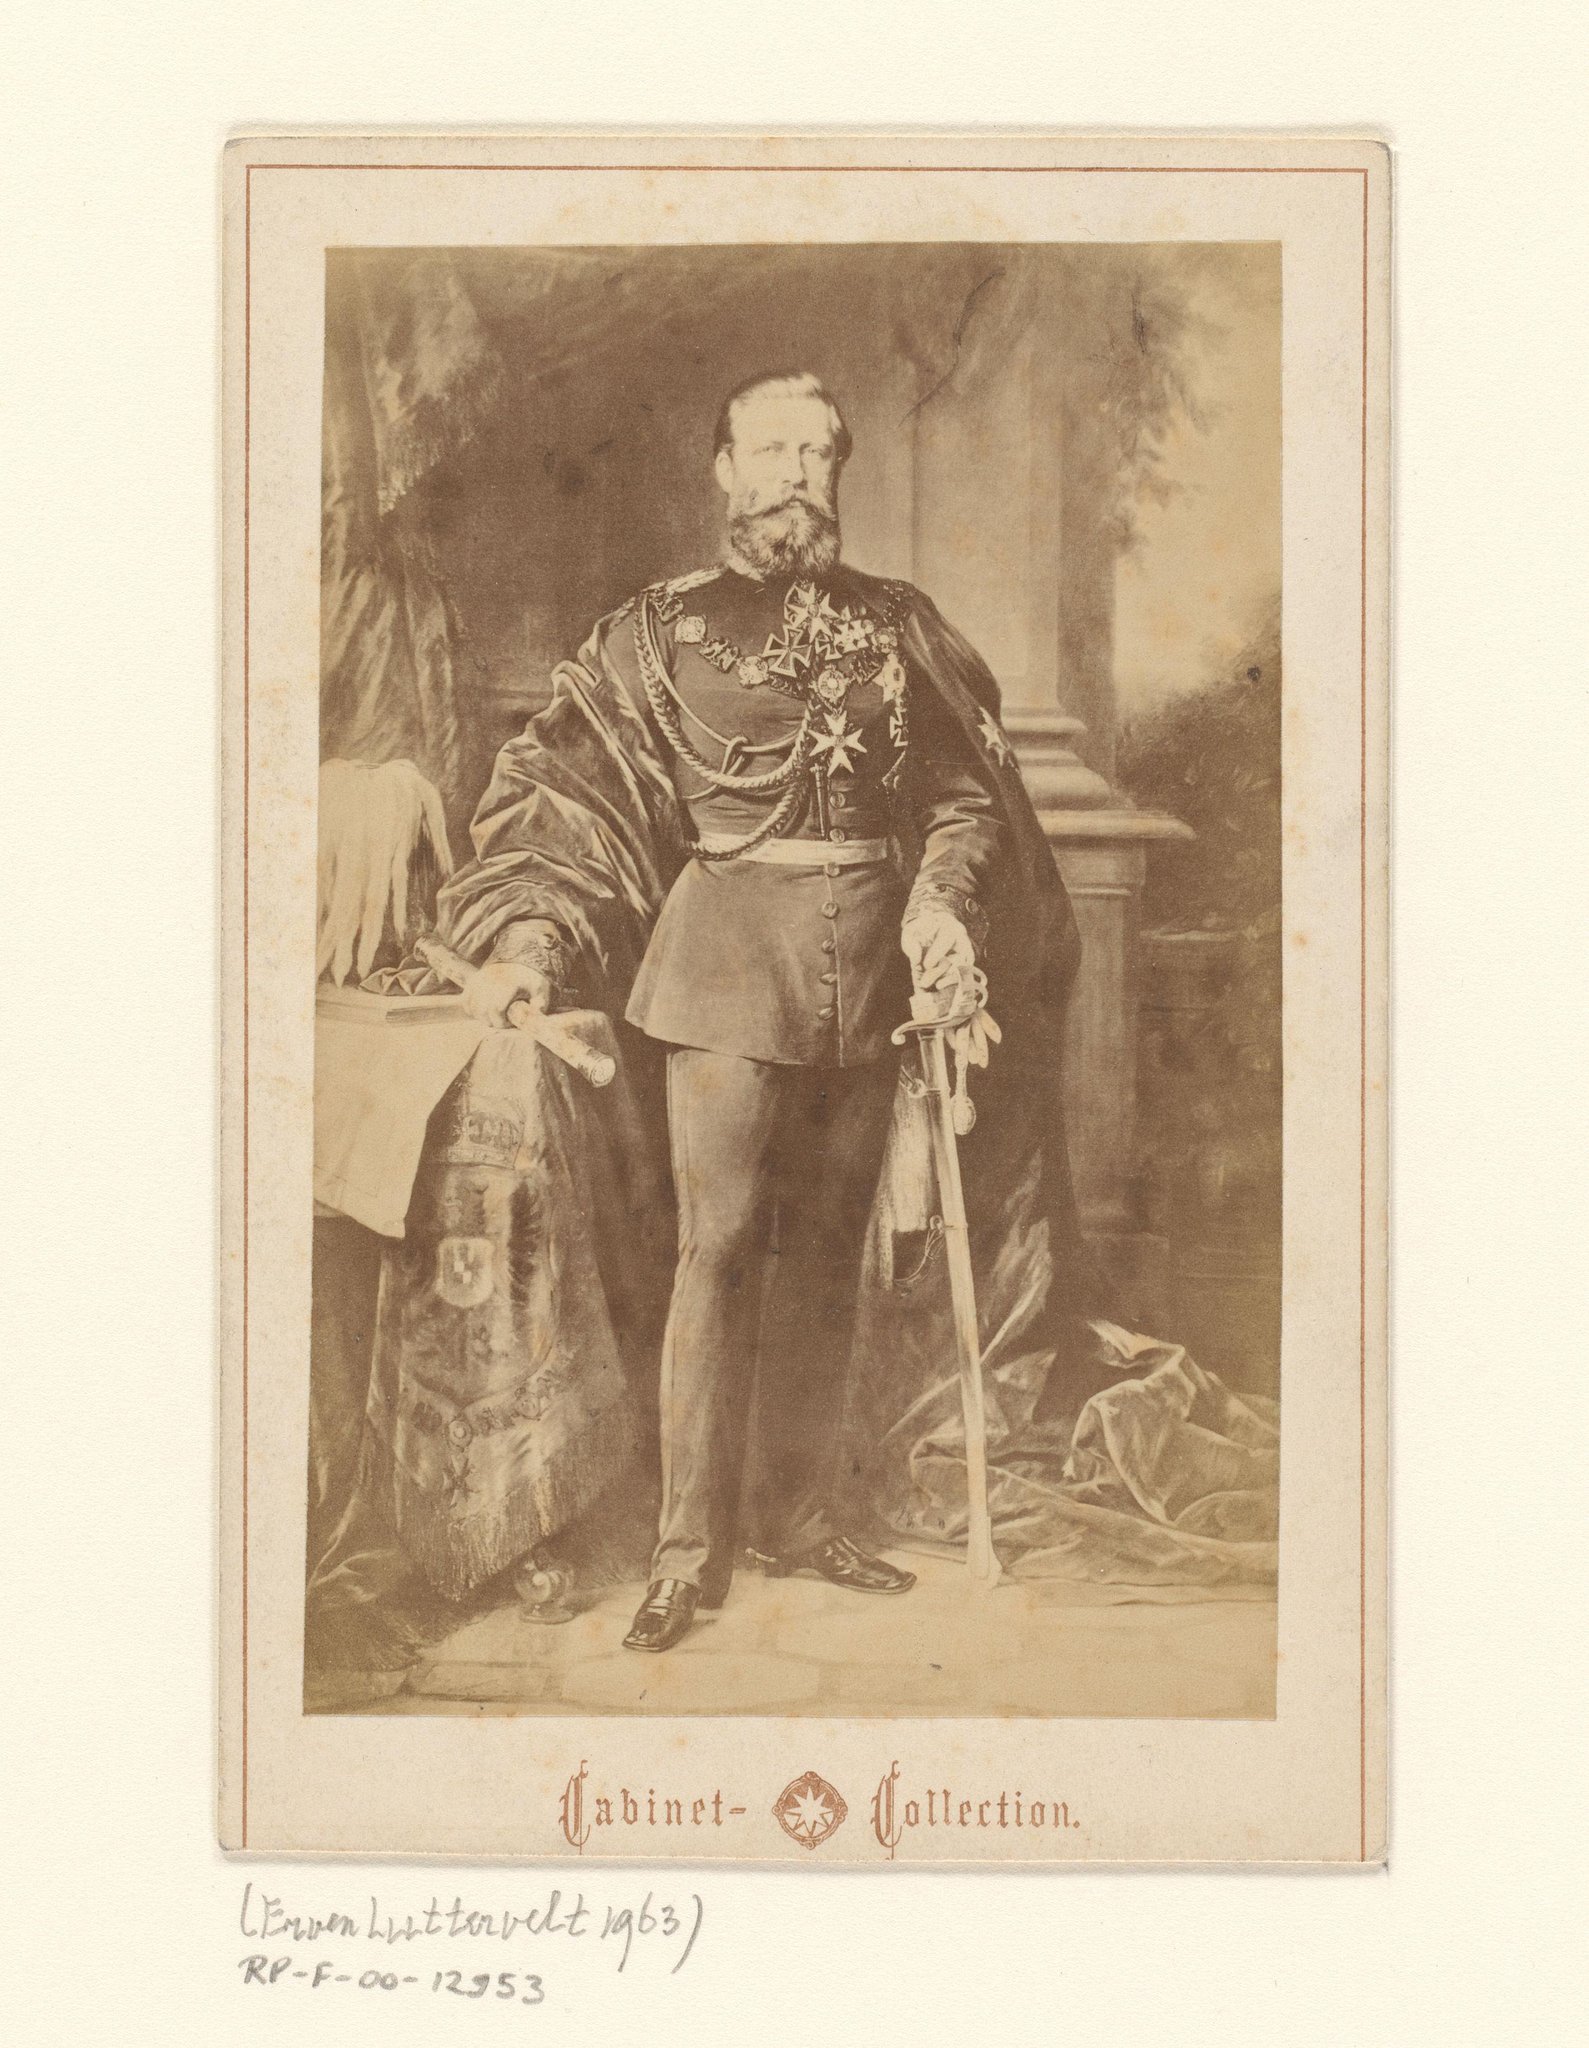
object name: cabinet photograph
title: Fotoreproductie van een geschilderd portret van Frederik III, keizer van Duitsland, in militair uniform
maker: Anonymous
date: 1888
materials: cardboard, paper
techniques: albumen print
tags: historical persons, emperor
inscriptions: inscription: ‘Keizer Friedrich III’, inscription: ‘ex Luttenvelt †1963’, inscription: ‘3/ E. Peiff [?] Friedrich Wilhelm Kron-[...]’